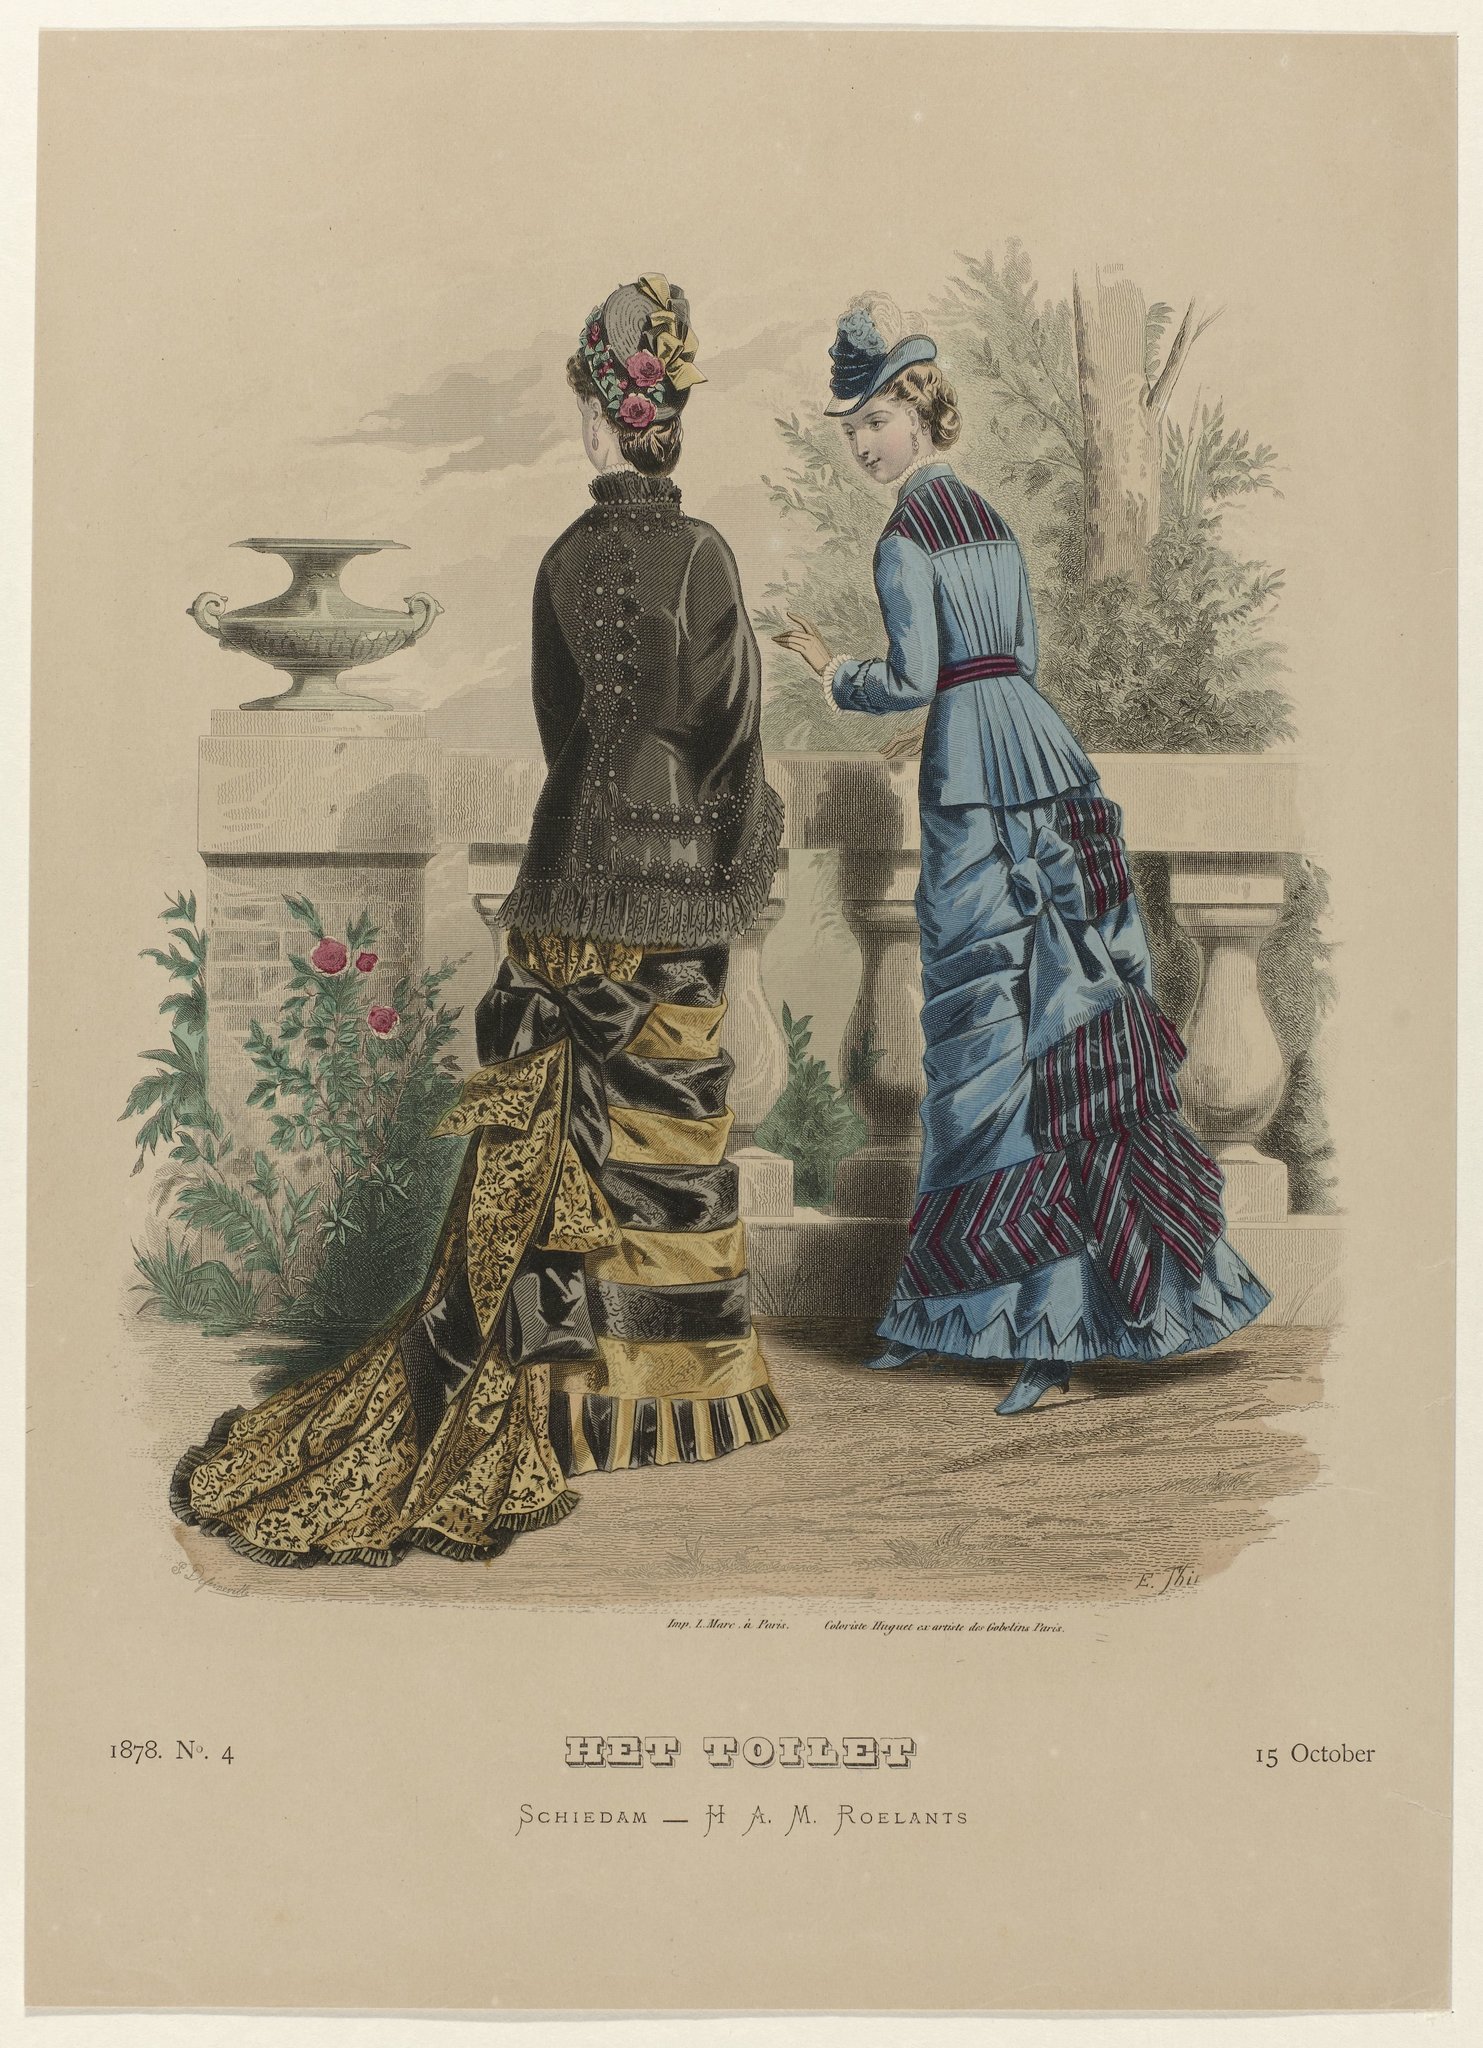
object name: fashion print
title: Het Toilet, 15 october 1878, No. 4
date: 1878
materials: paper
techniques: engraving, hand coloring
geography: paris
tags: fashion plates, dress, gown (+ women's clothes)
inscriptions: caption: ‘HET TOILET / SCHIEDAM - H.A.M. ROELANTS’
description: Prent uit het modetijdschrift Het Toilet (1877-?).